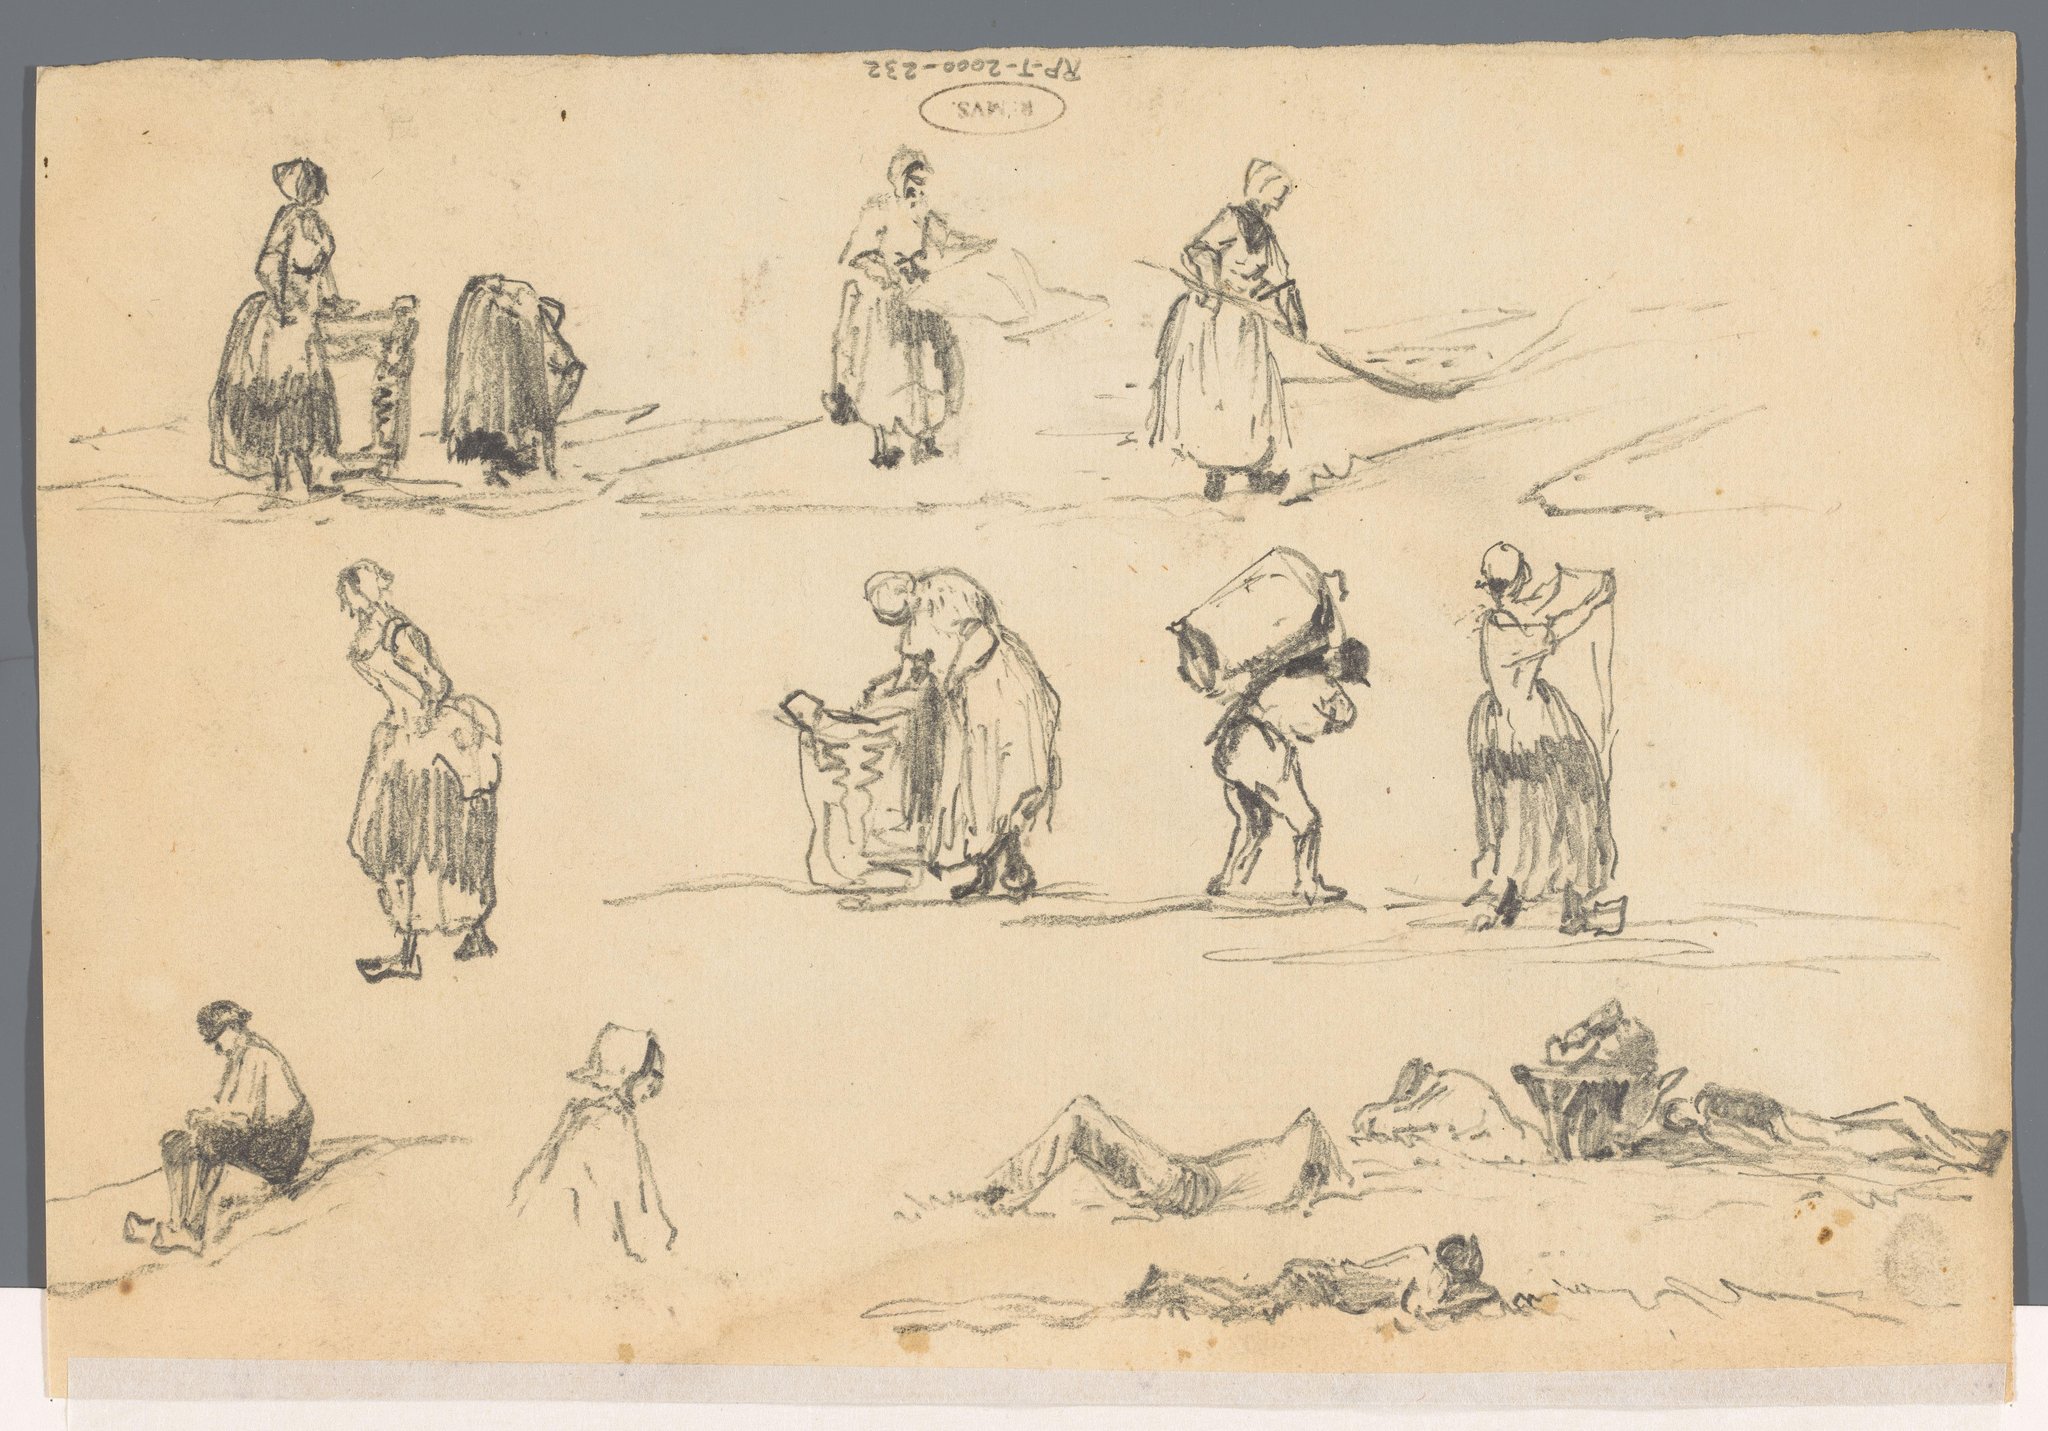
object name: drawing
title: Blad met studies van werkende figuren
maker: johannes tavenraat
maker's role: draughtsman, painter, print maker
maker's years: 1809-1881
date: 1840-1880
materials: paper, pencil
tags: farmers - aa - female farmer, farmer's wife, agriculture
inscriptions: collector's mark: Lugt 2228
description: Blad met verschillende studies van losse figuren, vrouwen en mannen, werkend.